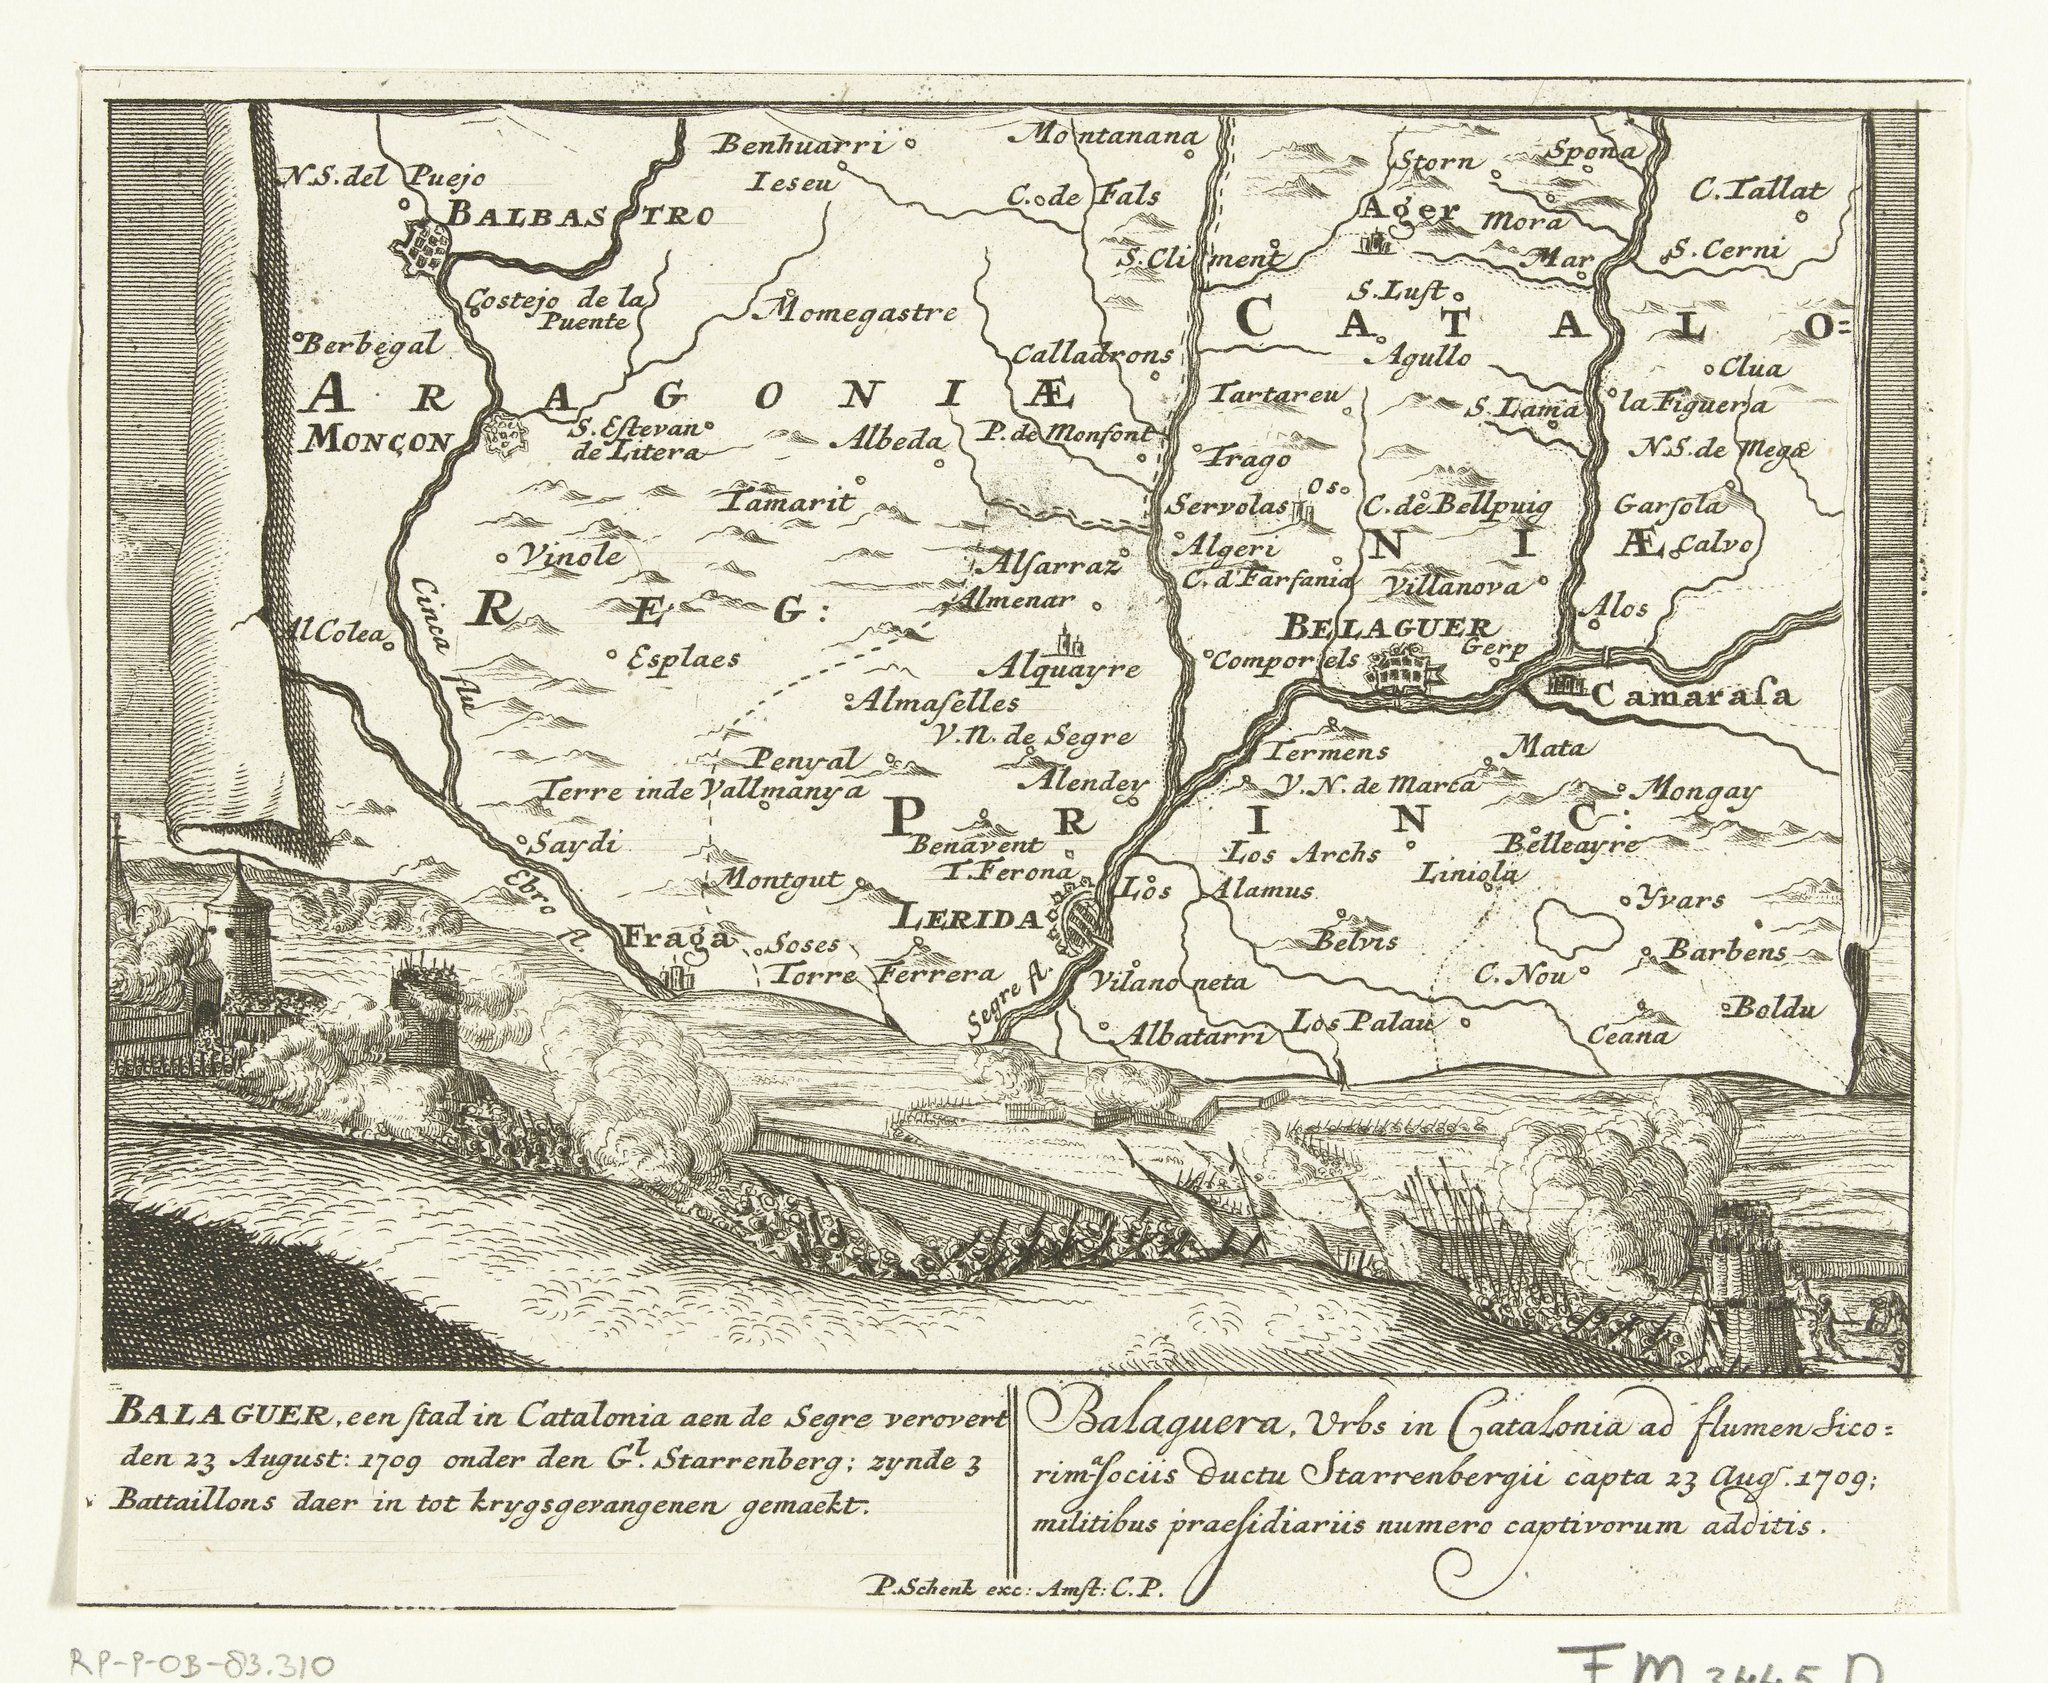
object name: print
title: Verovering van Balaguer, 1709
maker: pieter schenk (i)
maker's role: print maker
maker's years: 1660-1711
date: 1709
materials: paper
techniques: etching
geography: amsterdam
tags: siege, position war, maps of cities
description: Kaart van een deel van Catalonië, met de plaatsen Lerida en Balaguer, veroverd door de Geallieerden op 23 augustus 1709. Met onderschriften in het Nederlands en Latijn. Fragment van een grote plaat met negen voorstellingen van gebeurtenissen uit het jaar 1708 van de Spaanse Successieoorlog.